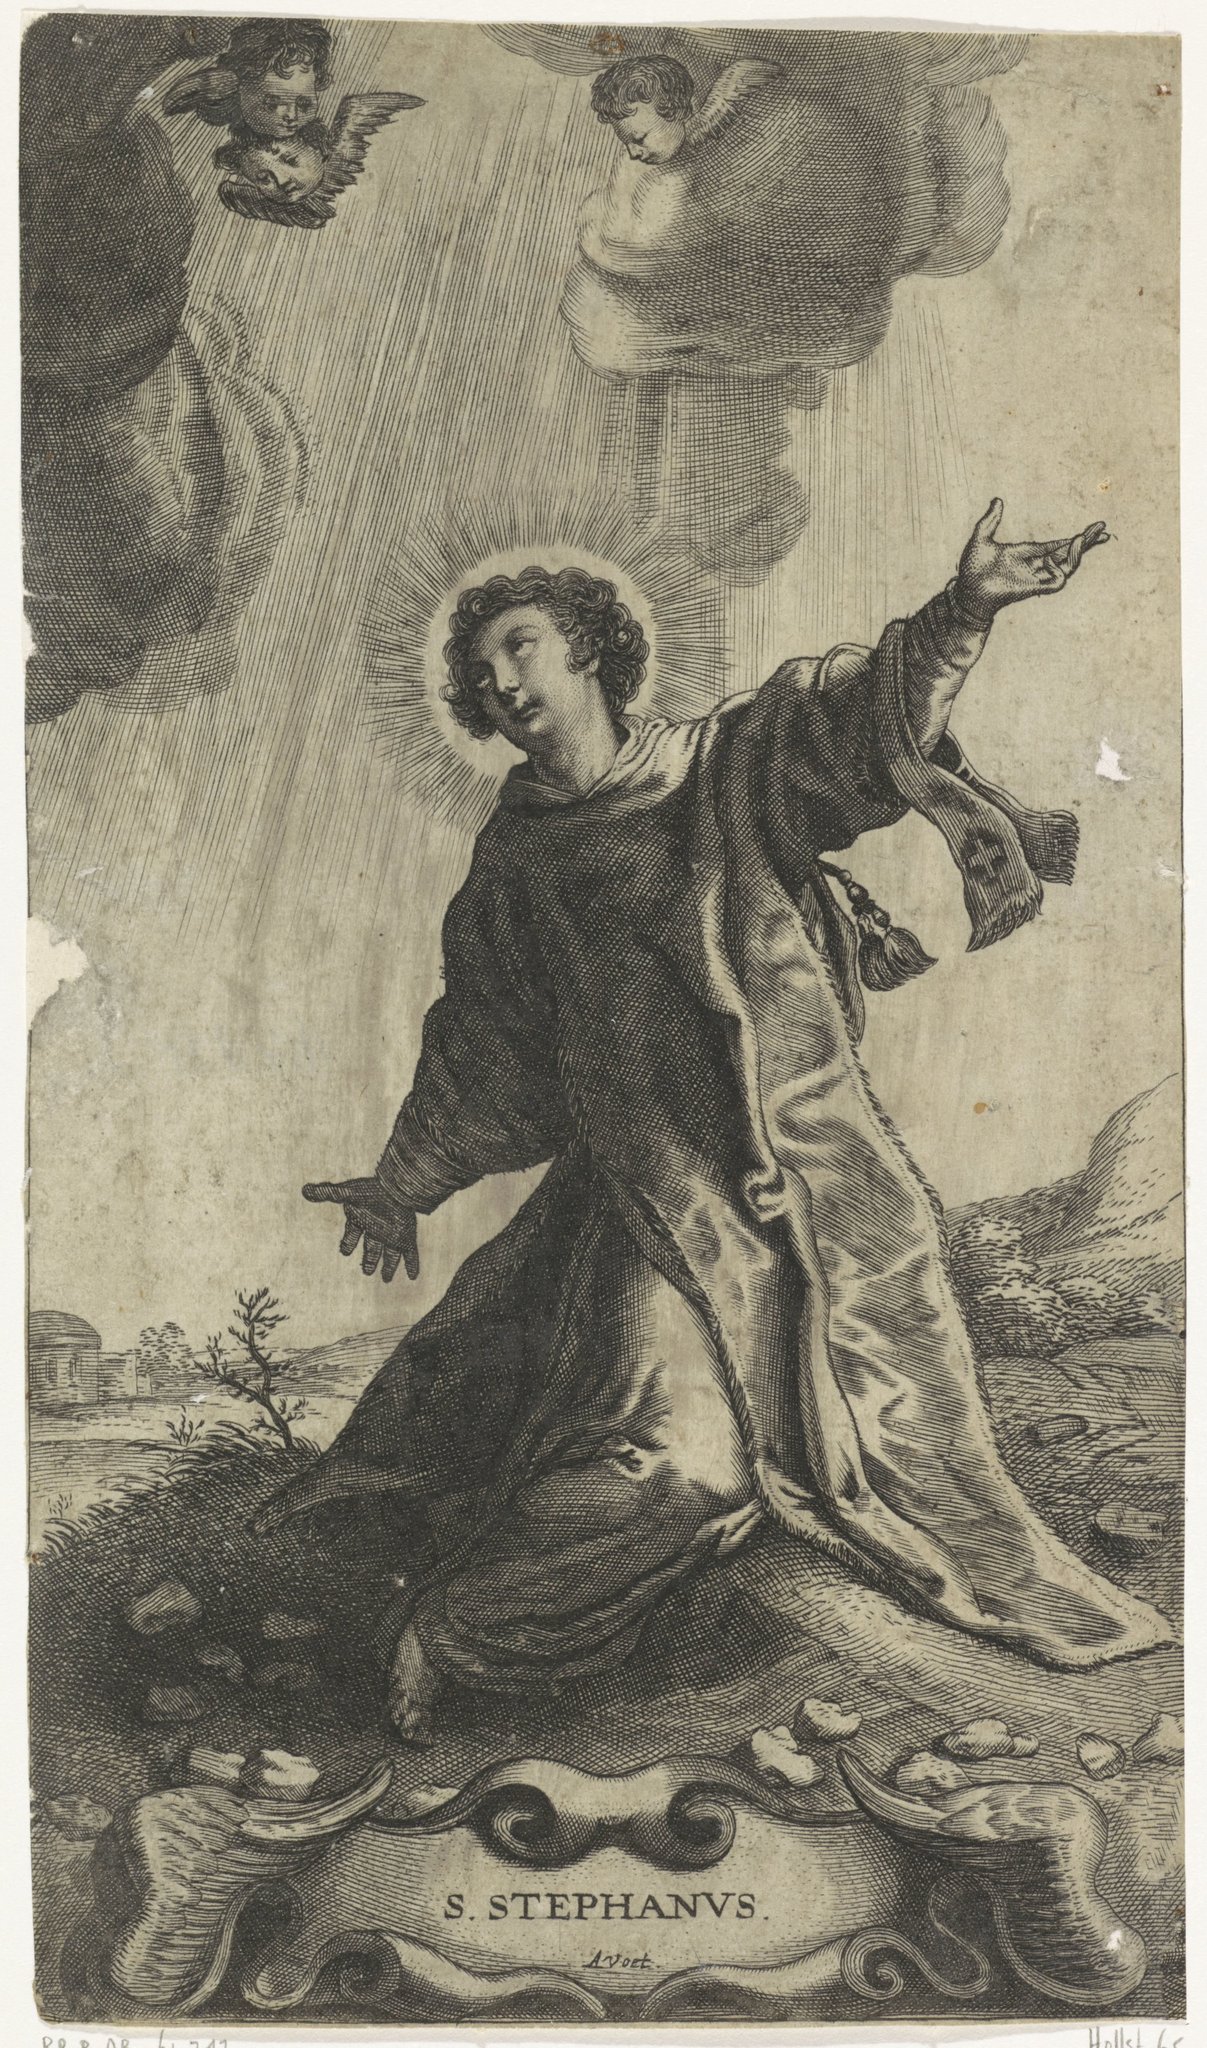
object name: print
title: H. Stephanus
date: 1628-1689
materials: paper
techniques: engraving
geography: antwerp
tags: the deacon and (proto)martyr stephen; possible attributes: censer, stones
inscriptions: collector's mark: Lugt 2228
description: De heilige Stephanus omringd met stenen die verwijzen naar zijn martelaarschap. In de lucht drie cherubijnen.